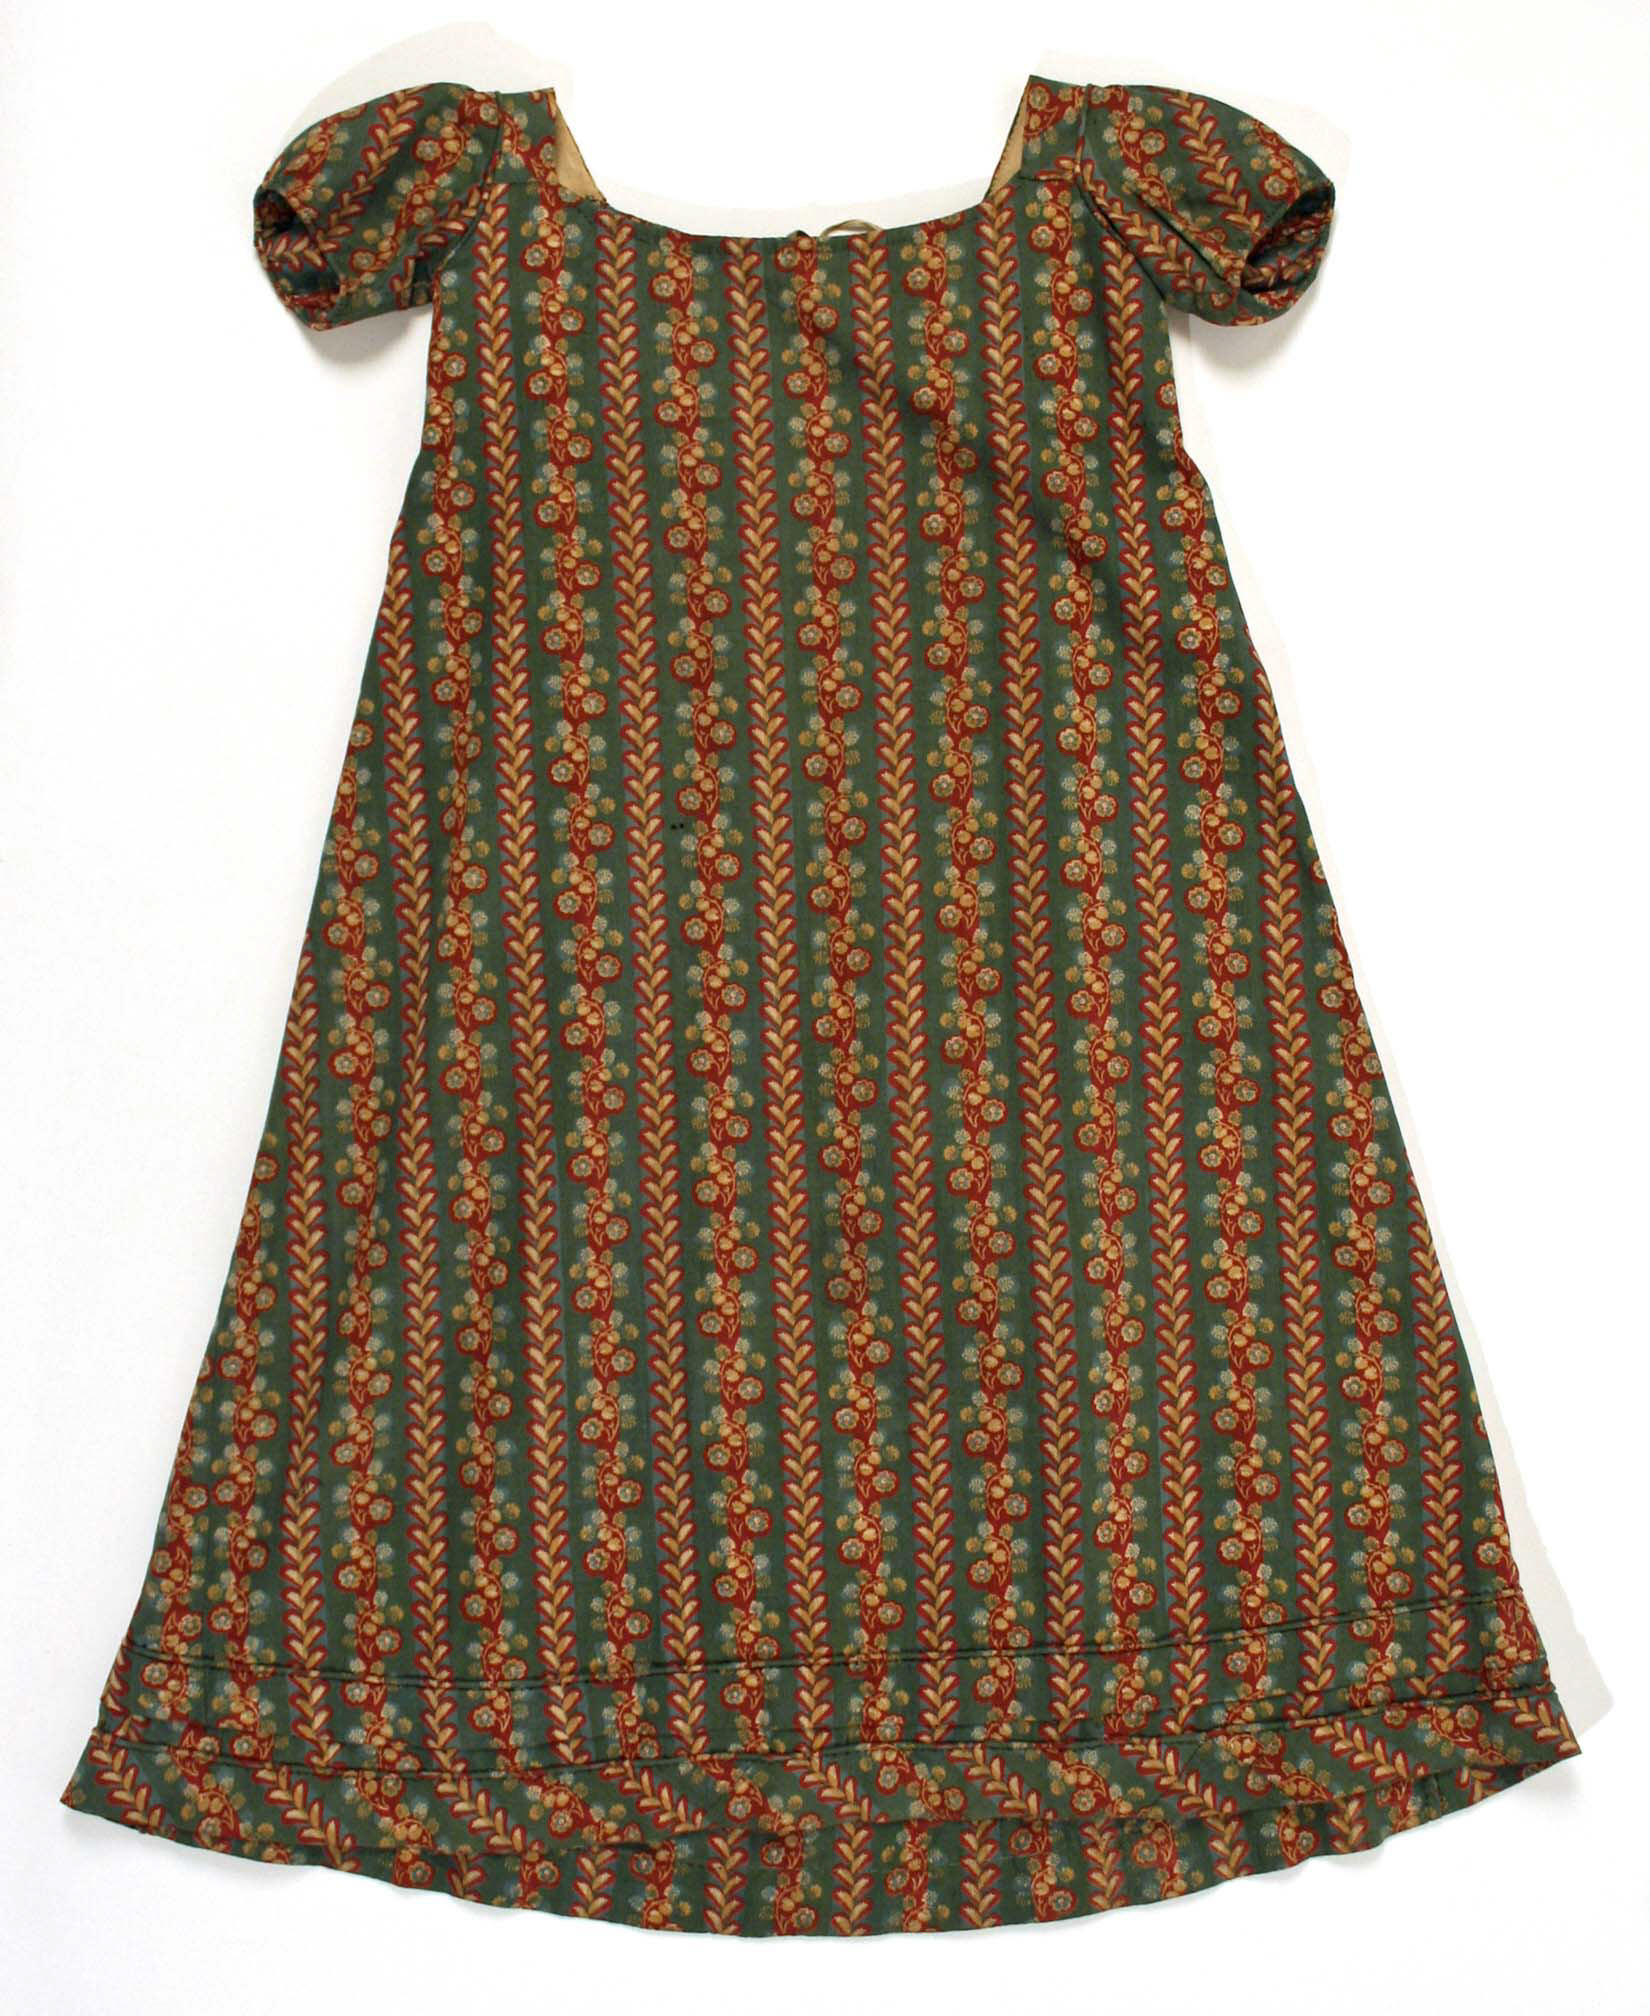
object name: dress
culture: american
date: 1801-1833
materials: cotton